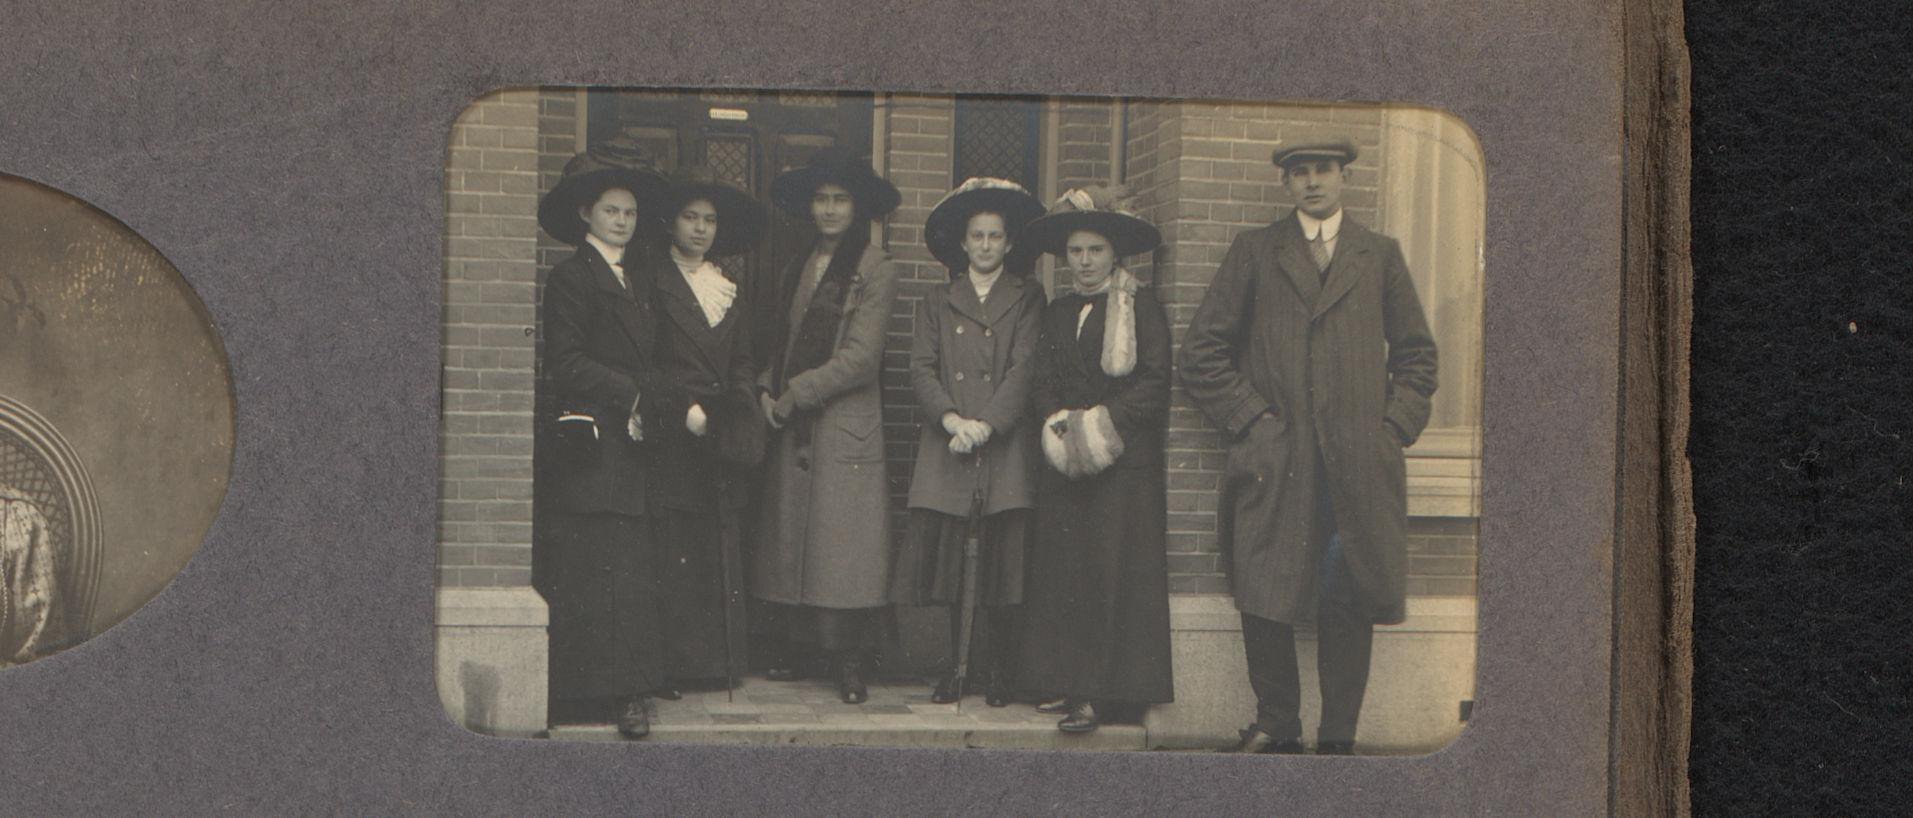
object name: album leaf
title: Groepsportret voor een huis met Wiesje Merkus, Bertha Huygens de Raat, Jenny Wichers, Gretha, Pauline van den Bussche en Theo Wichers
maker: Anonymous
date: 1911-1912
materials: paper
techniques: gelatin silver print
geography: gelderland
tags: the hague, artist, sculptor, jenny cornelia henriette wichers (jane), adolescent, young woman, maiden, youth, adolescent, anonymous historical persons portrayed in a group, in a group-portrait, gelderland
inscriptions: inscription: ‘Kerstbal. 1911.’